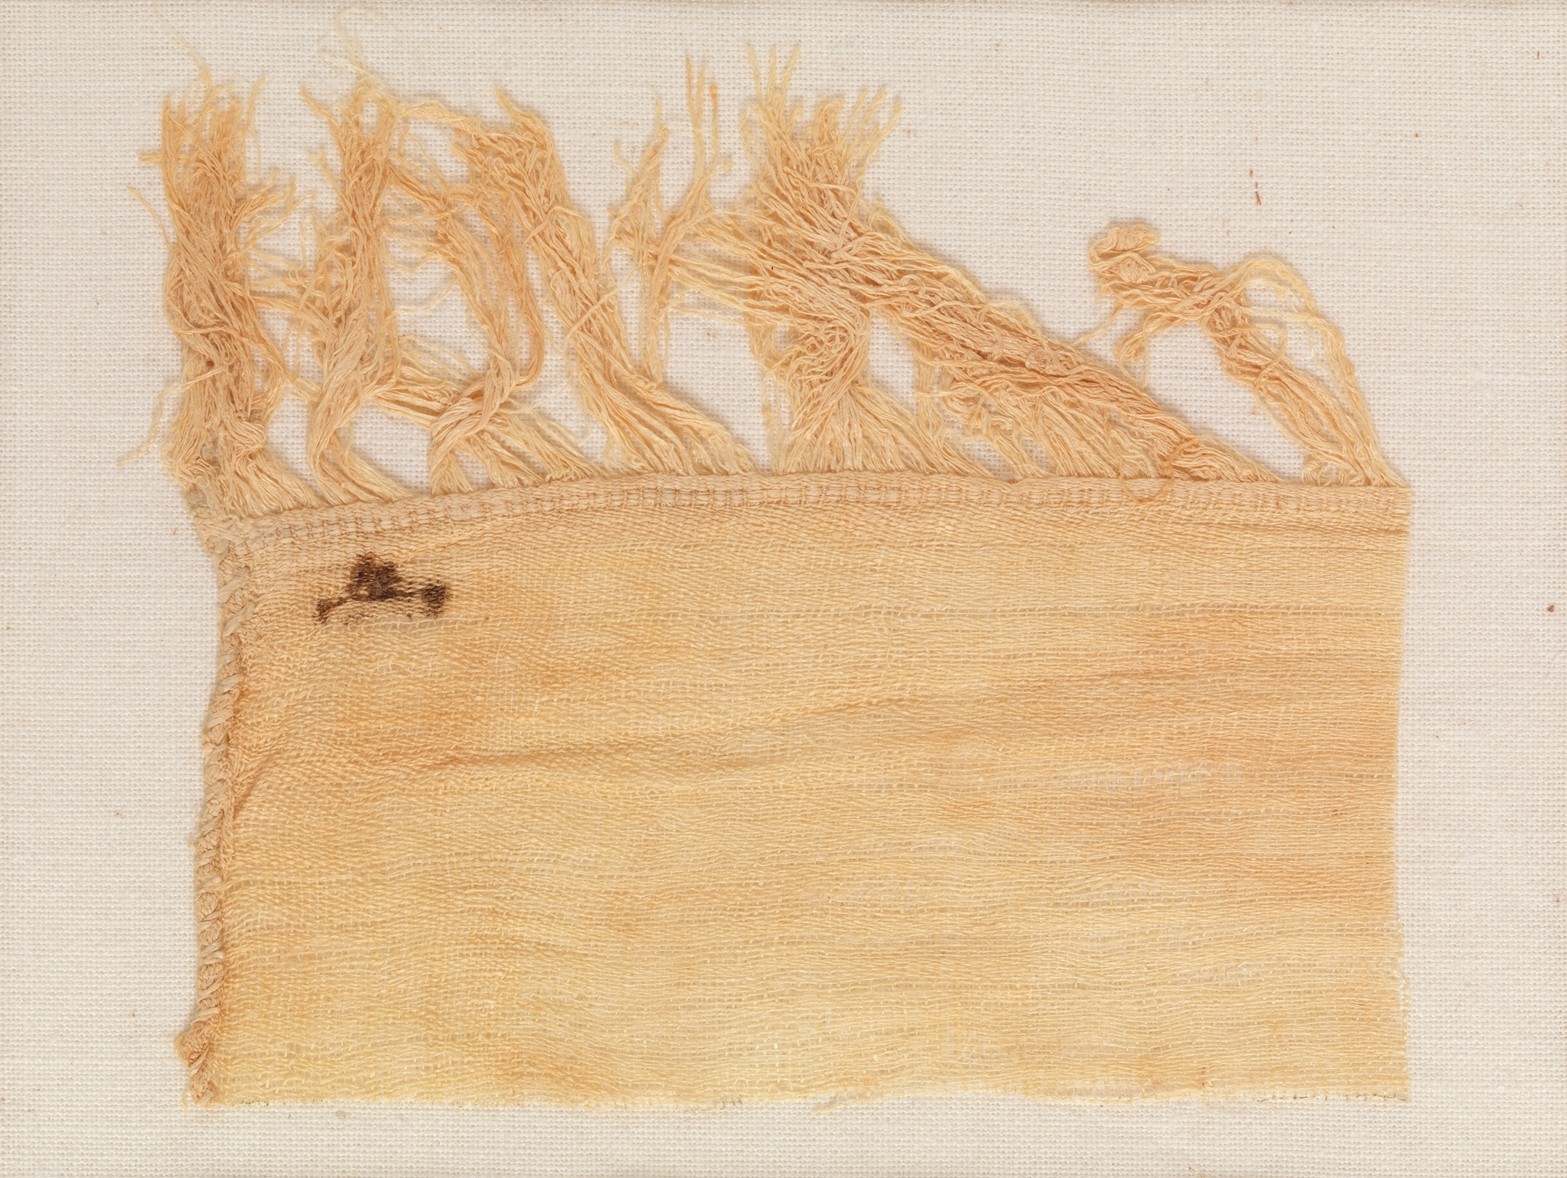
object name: linen mark, wah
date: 1981-1975 BCE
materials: linen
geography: egypt